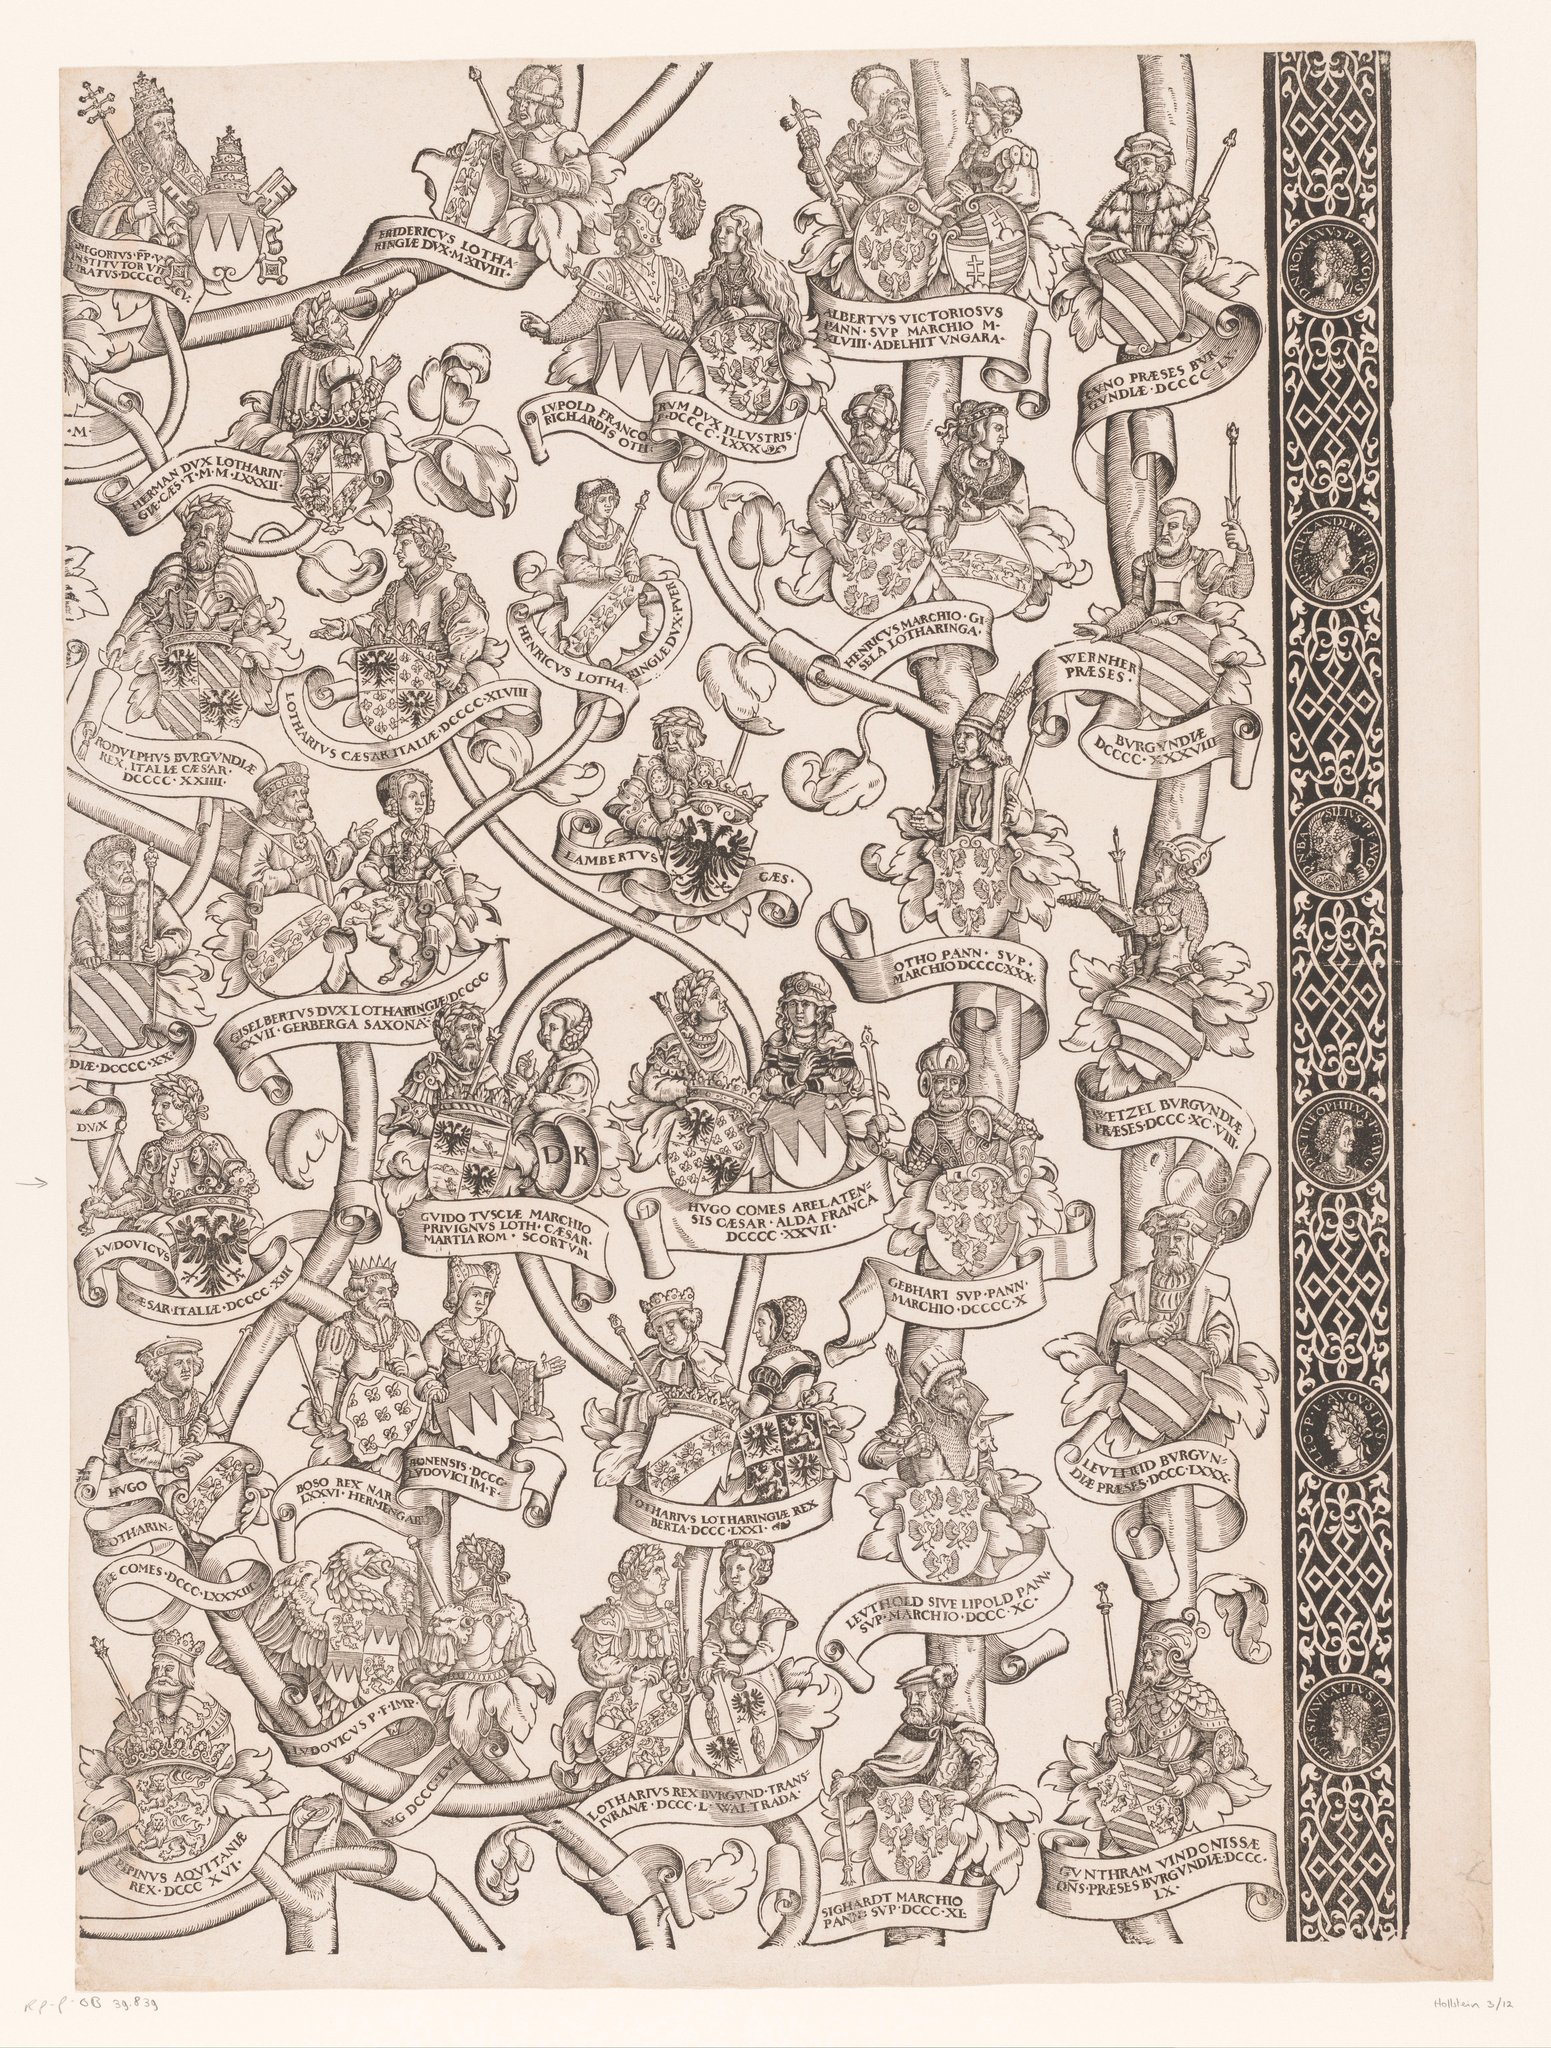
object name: print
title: Stamboom van Frederik en Ottheinrich van Palts-Neuburg (plaat 12)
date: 1535-1594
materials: paper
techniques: letterpress printing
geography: basel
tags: earl, family lineage, pedigree, genealogical tree or table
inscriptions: collector's mark: Lugt 240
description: Blad 12 van een stamboom bestaande uit 21 bladen, gedrukt van 42 blokken.